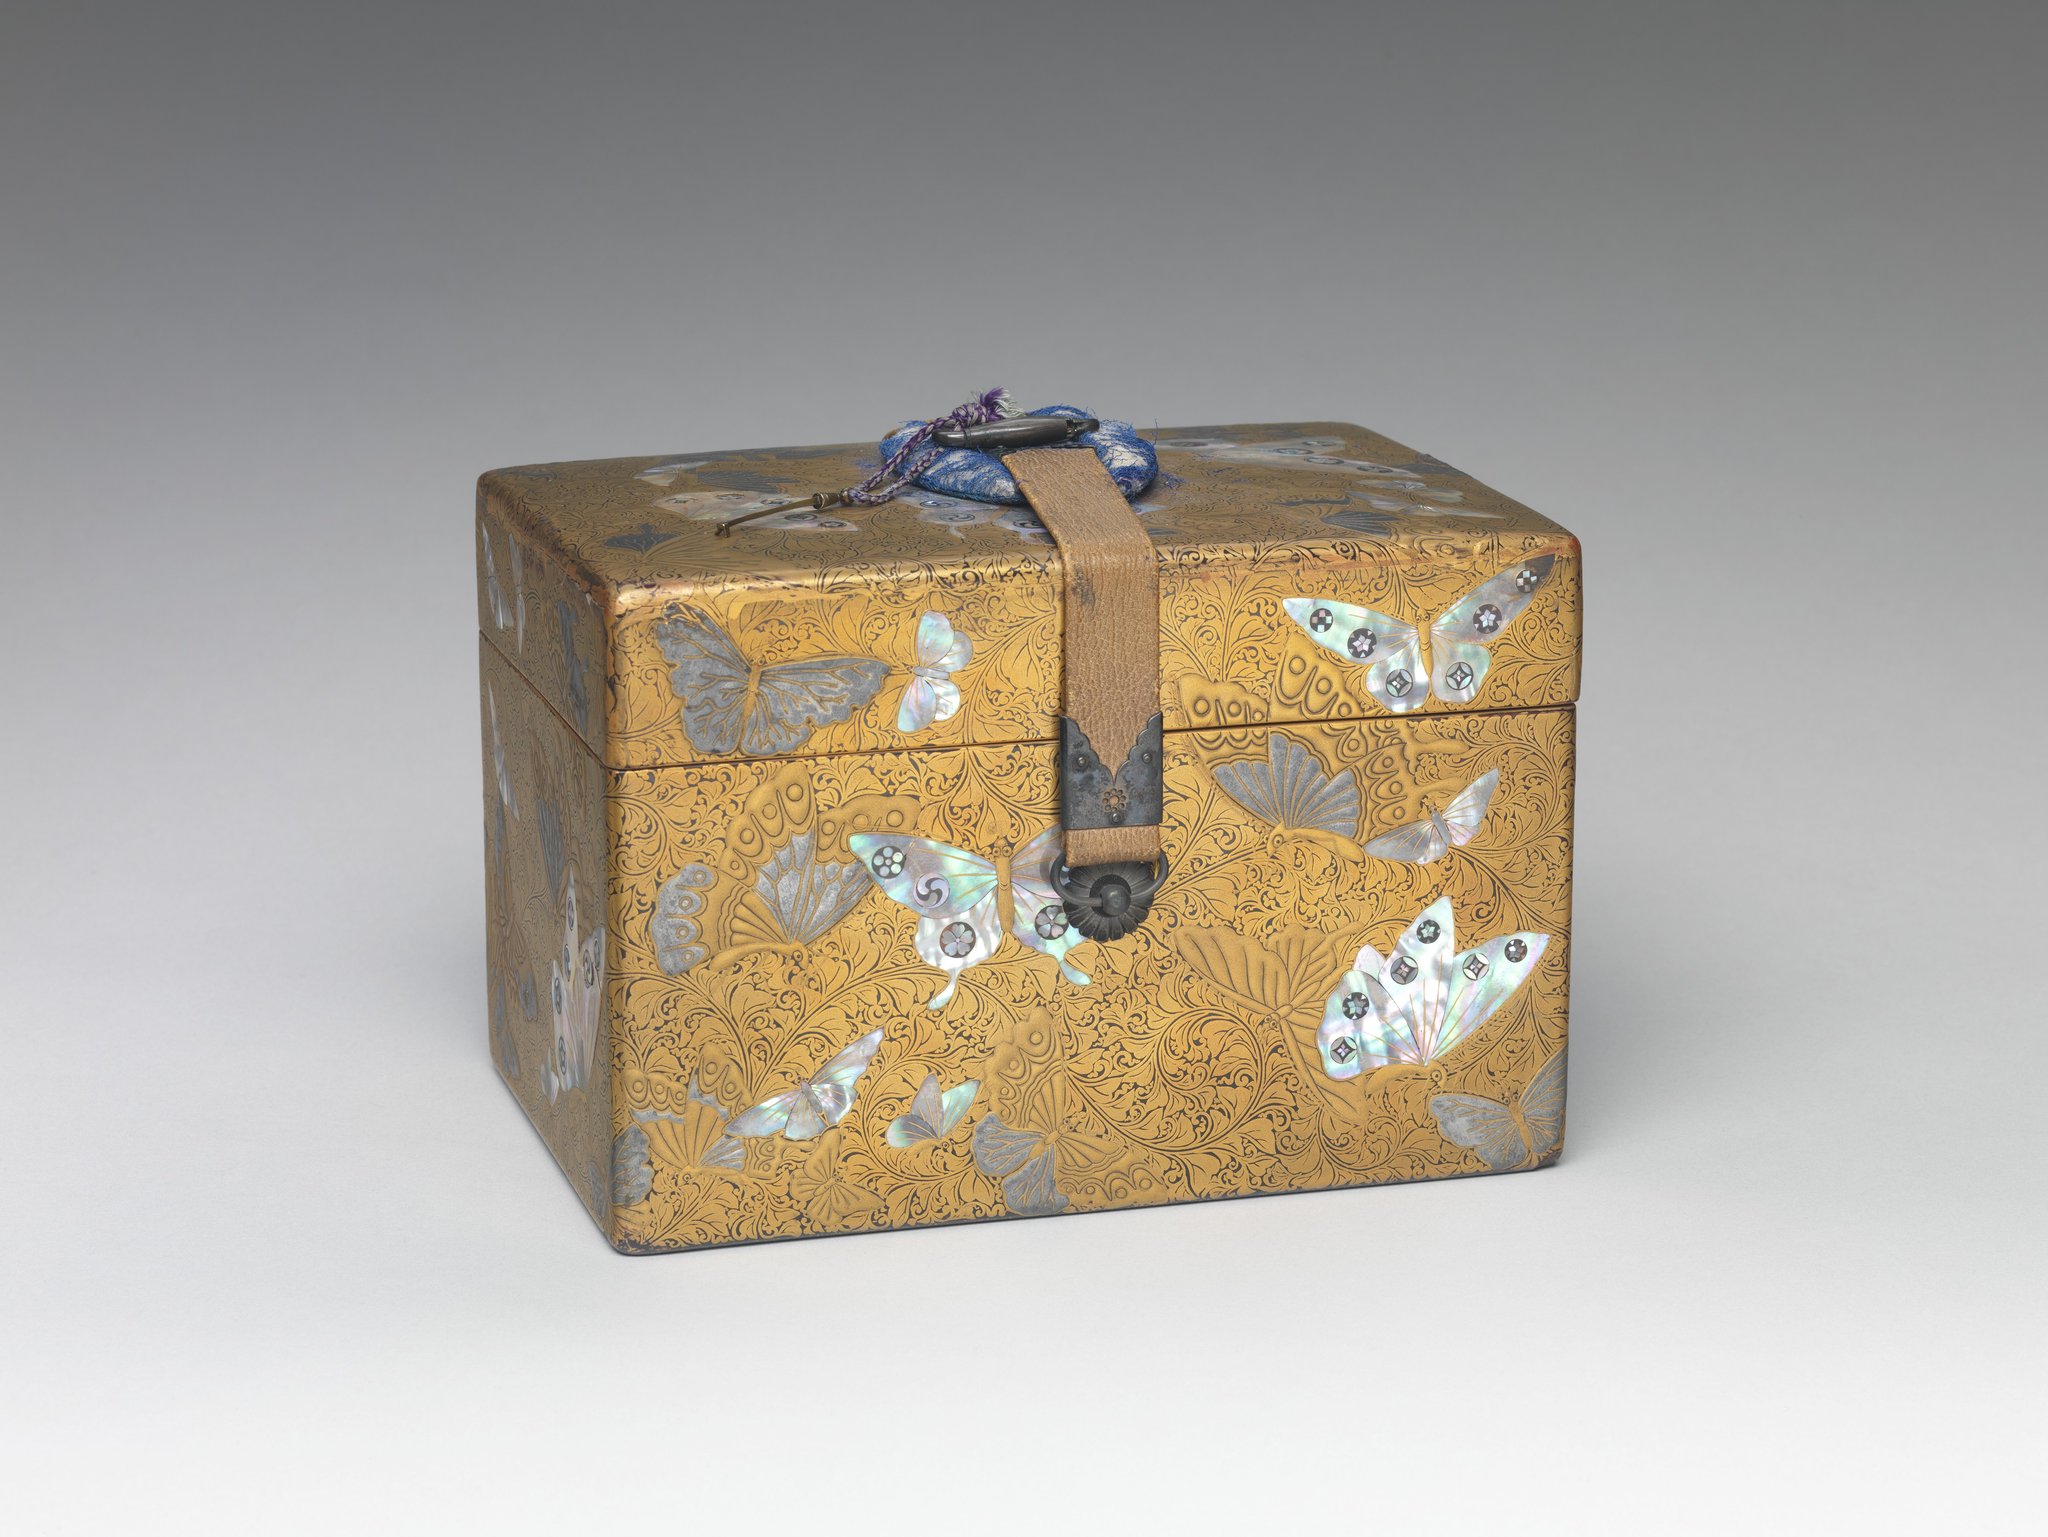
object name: box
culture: japanese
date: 1834-1866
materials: gold, lacquer, leather, metal, mother of pearl, silver, wood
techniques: hiramakie, inlay, lacquer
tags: butterflies